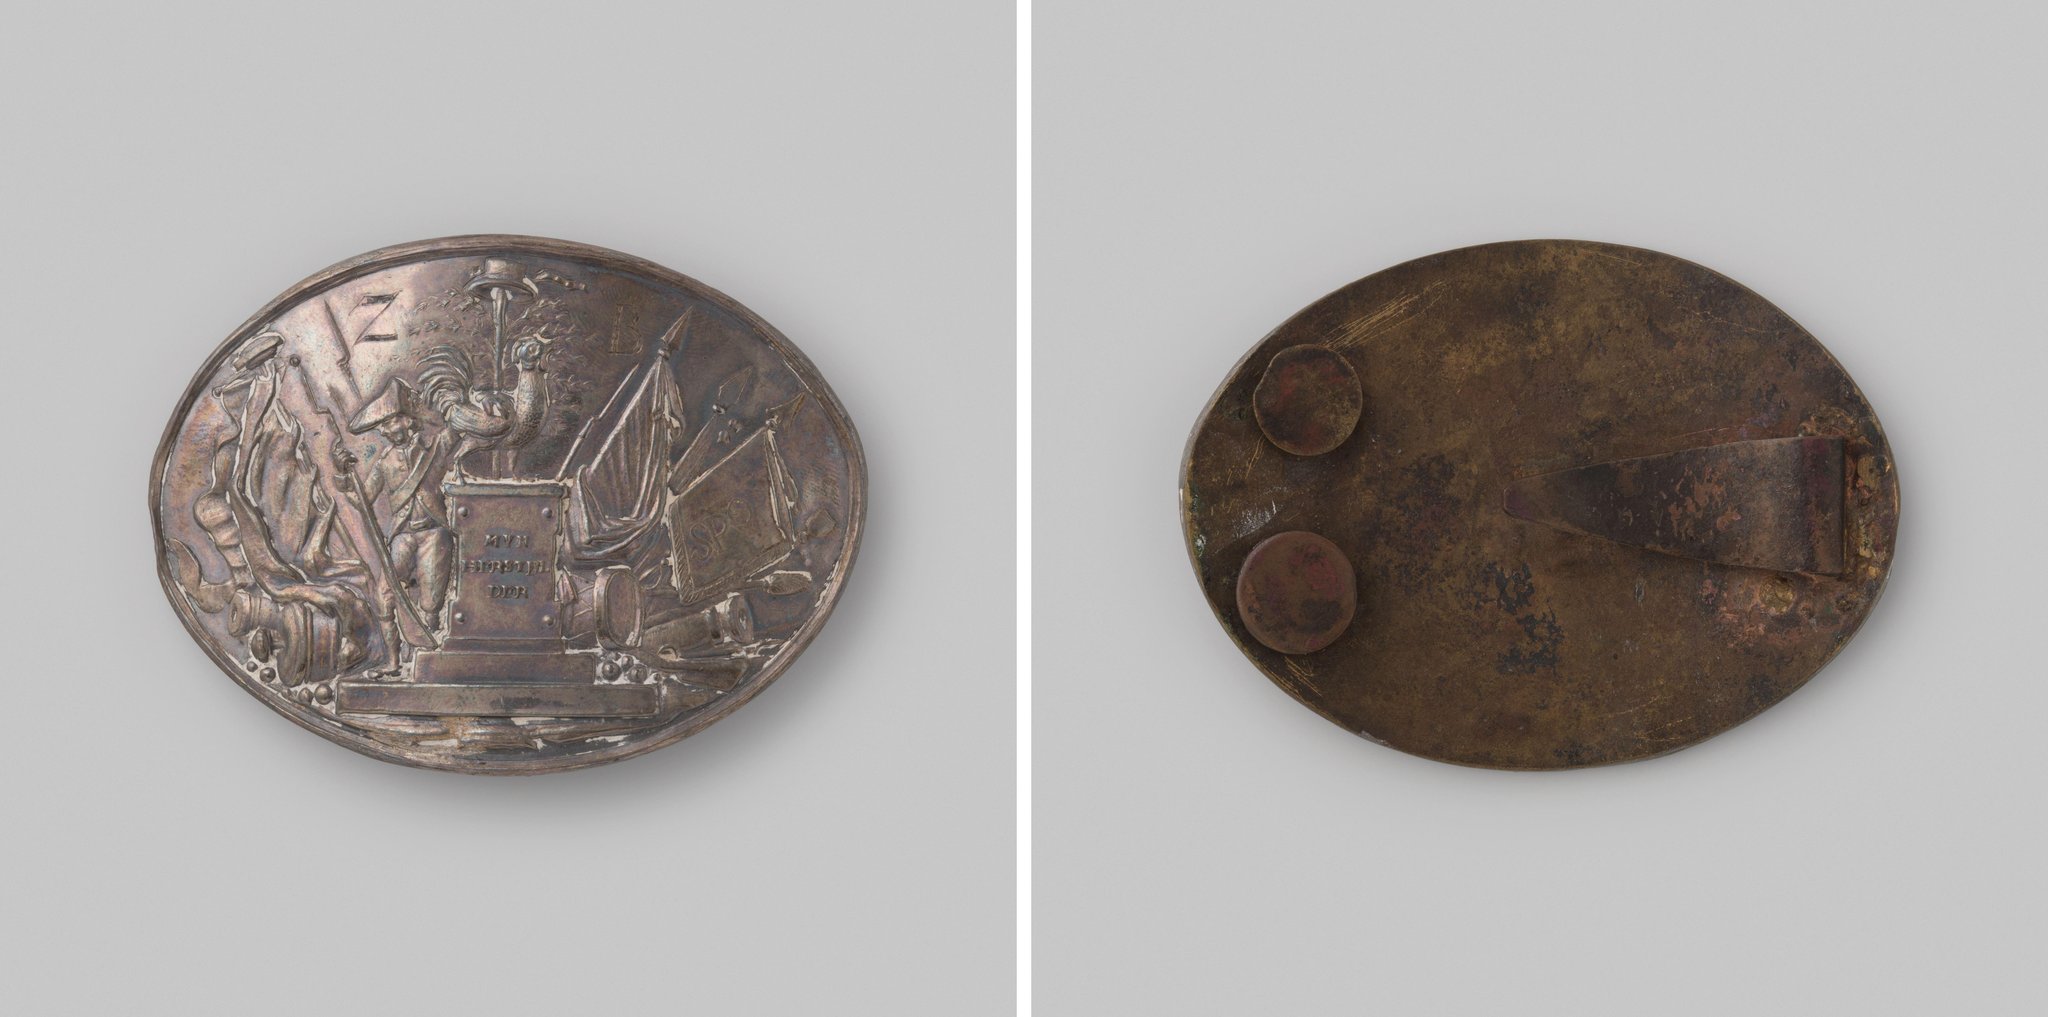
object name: medal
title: Ovaal bewerkte plaat met historische voorstelling voorzijde en bevestigingsclip aan achterzijde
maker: Anonymous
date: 1700-1899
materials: metal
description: Ovaal metalen plaat, voorzijde met afbeelding, achterzijde met bevestigingsclip.